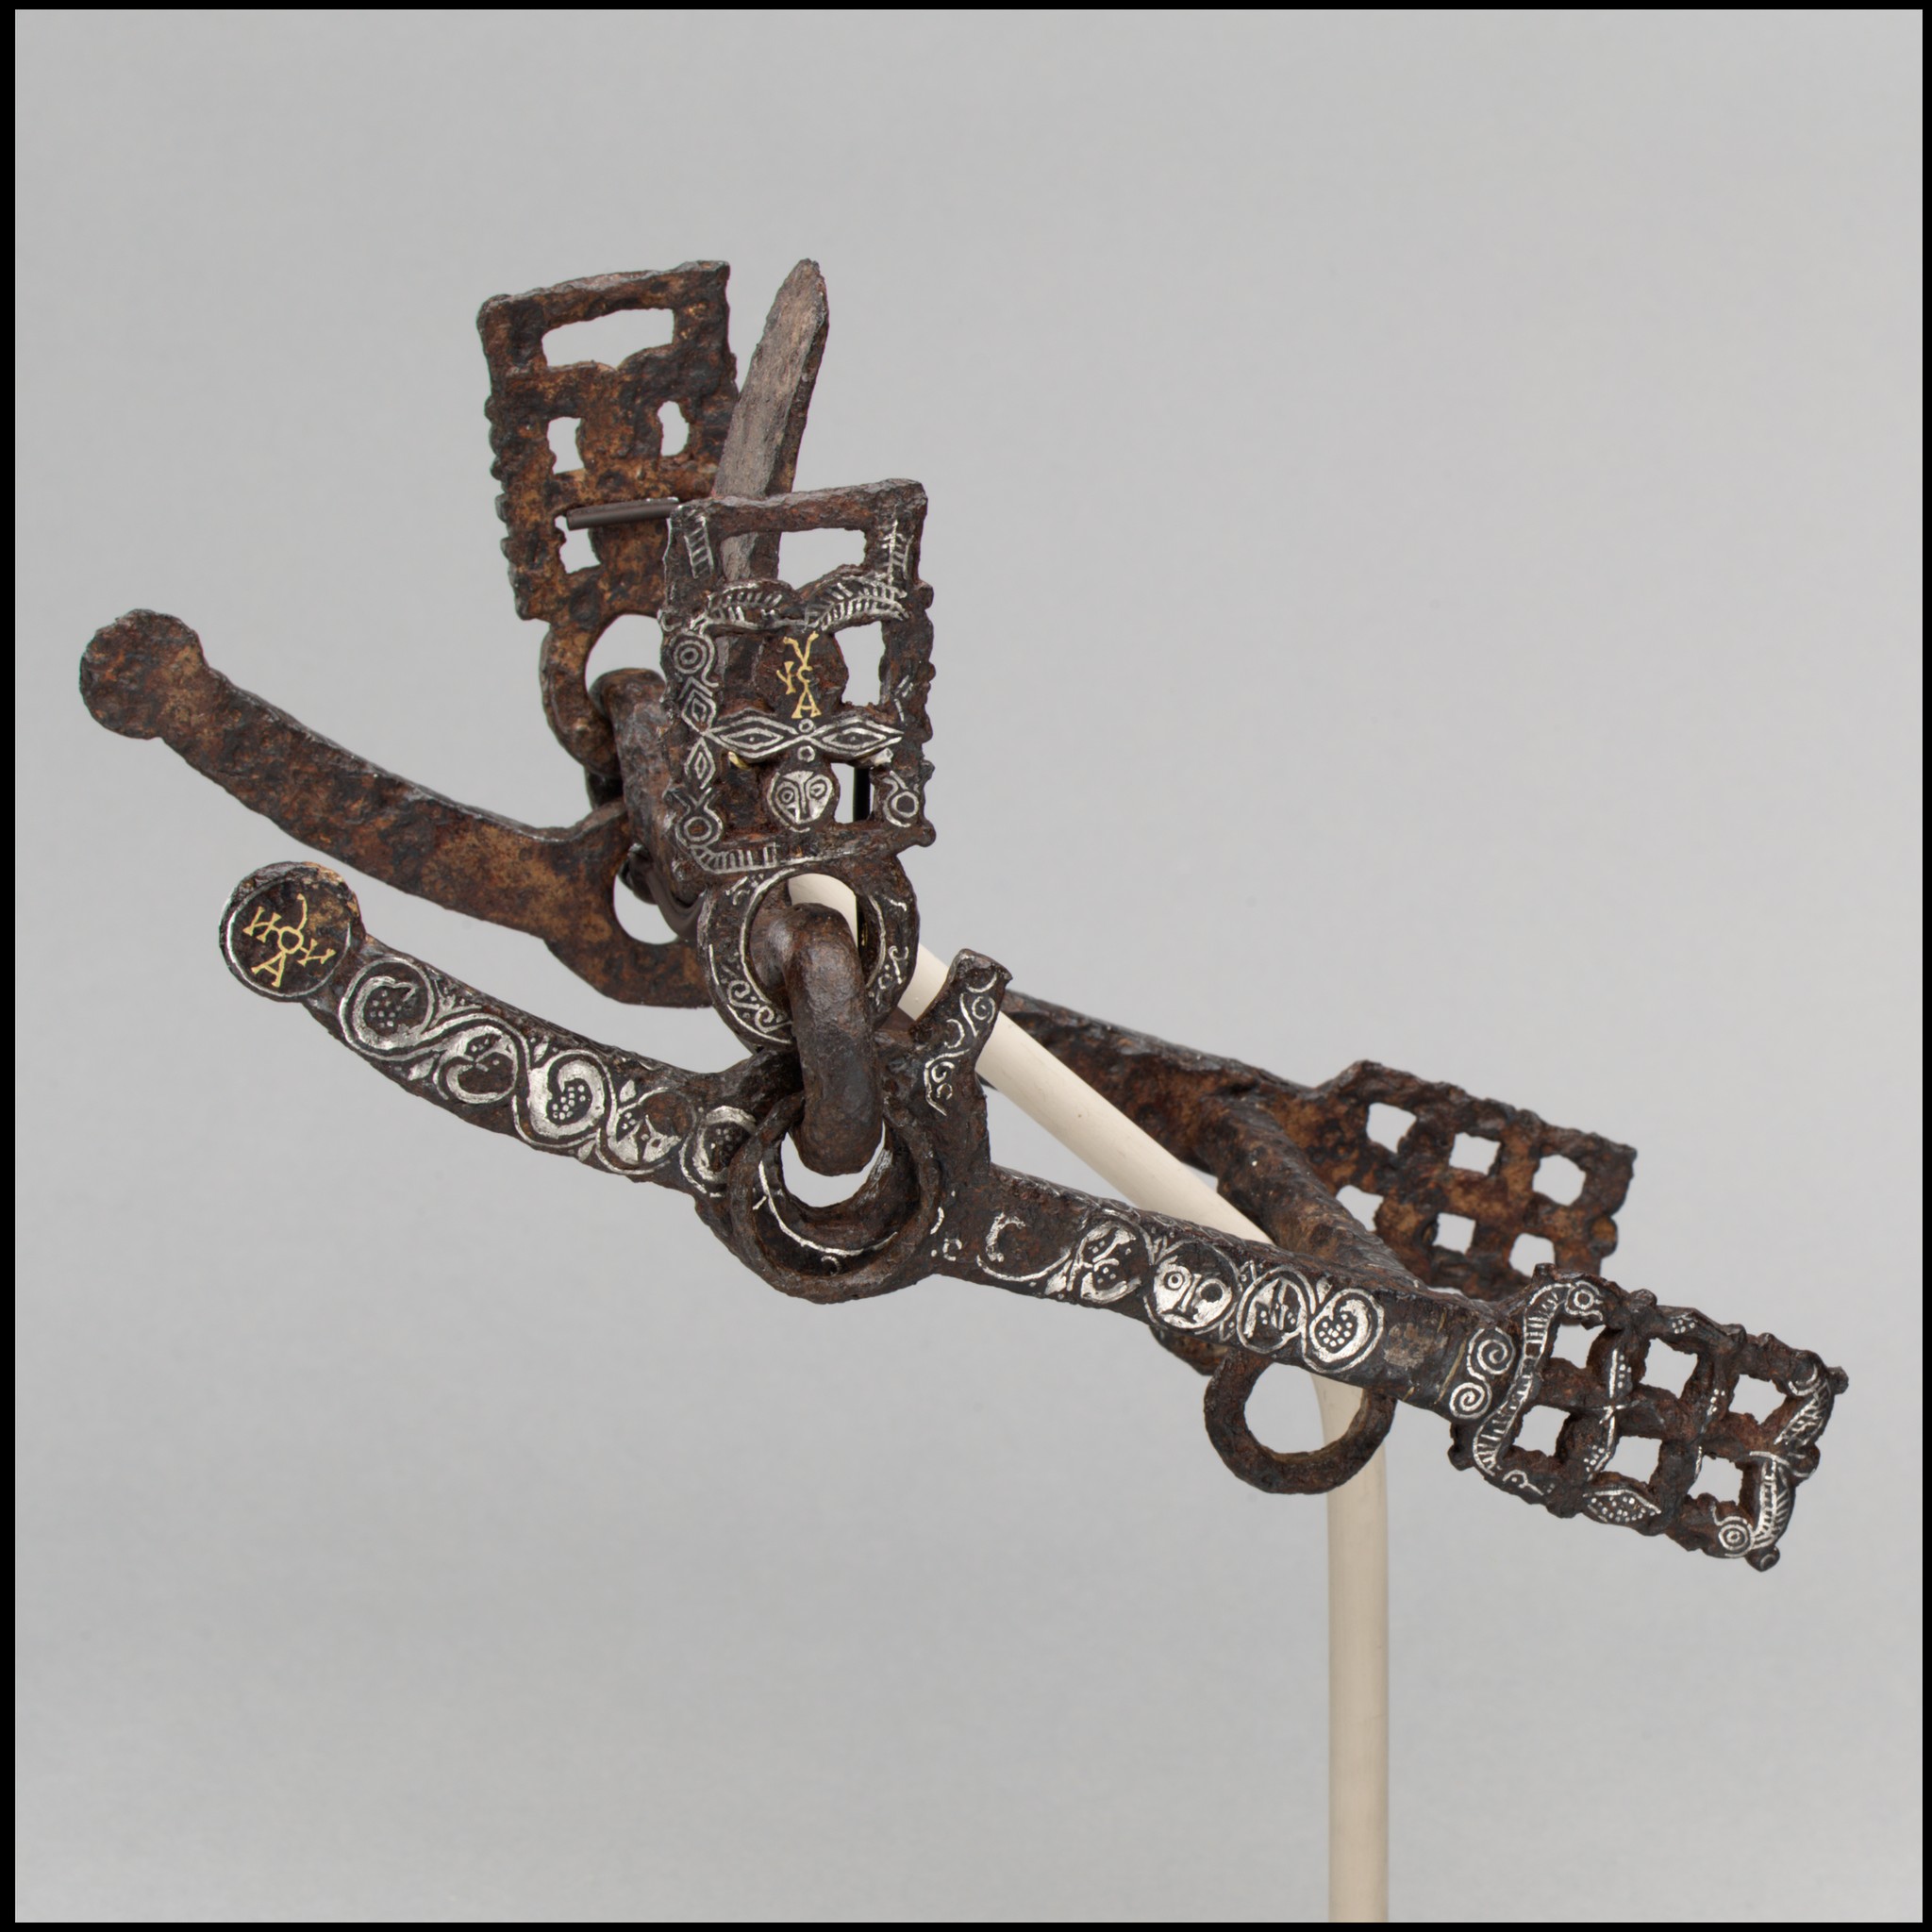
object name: bit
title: Horse Bit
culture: byzantine or visigothic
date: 601-900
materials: copper alloy, gold, iron, silver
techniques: inlay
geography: spain